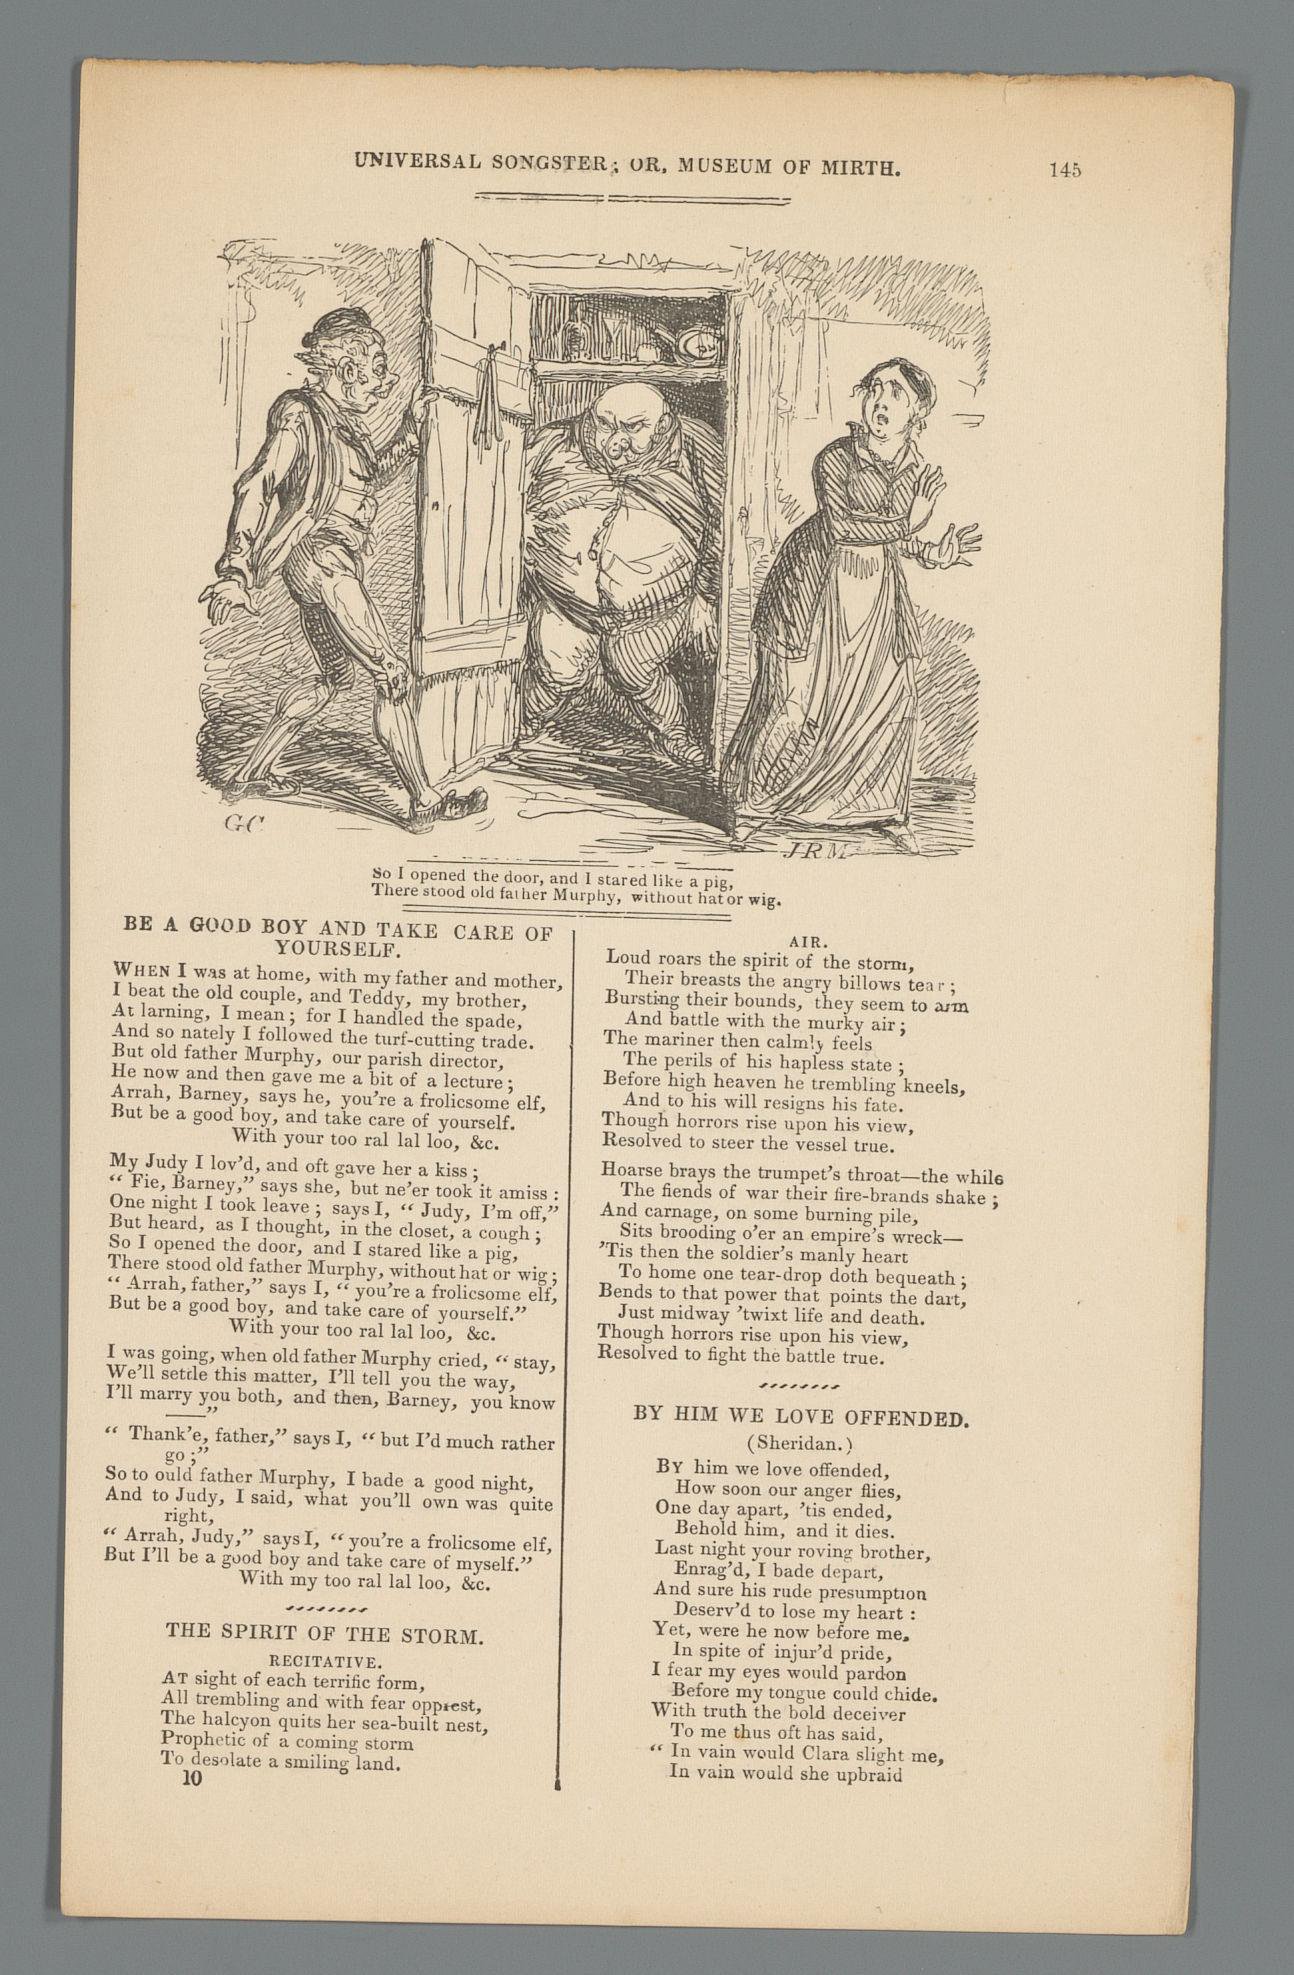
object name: book illustration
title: Be a good boy and take care of yourself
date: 1825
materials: paper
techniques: engraving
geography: england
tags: cupboard, political caricatures and satires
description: Een Ierse man opent de deur van een kast en treft daarin 'old father Murphey', een jonge vrouw loopt geschrokken weg. Spotprent bij een blad met de tekst van het lied: Be a good boy and take care of yourself. Illustratie (p. 145/146) genomen uit een uitgave van de liederenbundel: The Universal Songster, or Museum of Mirth, vol. I., eerst verschenen in 1825.